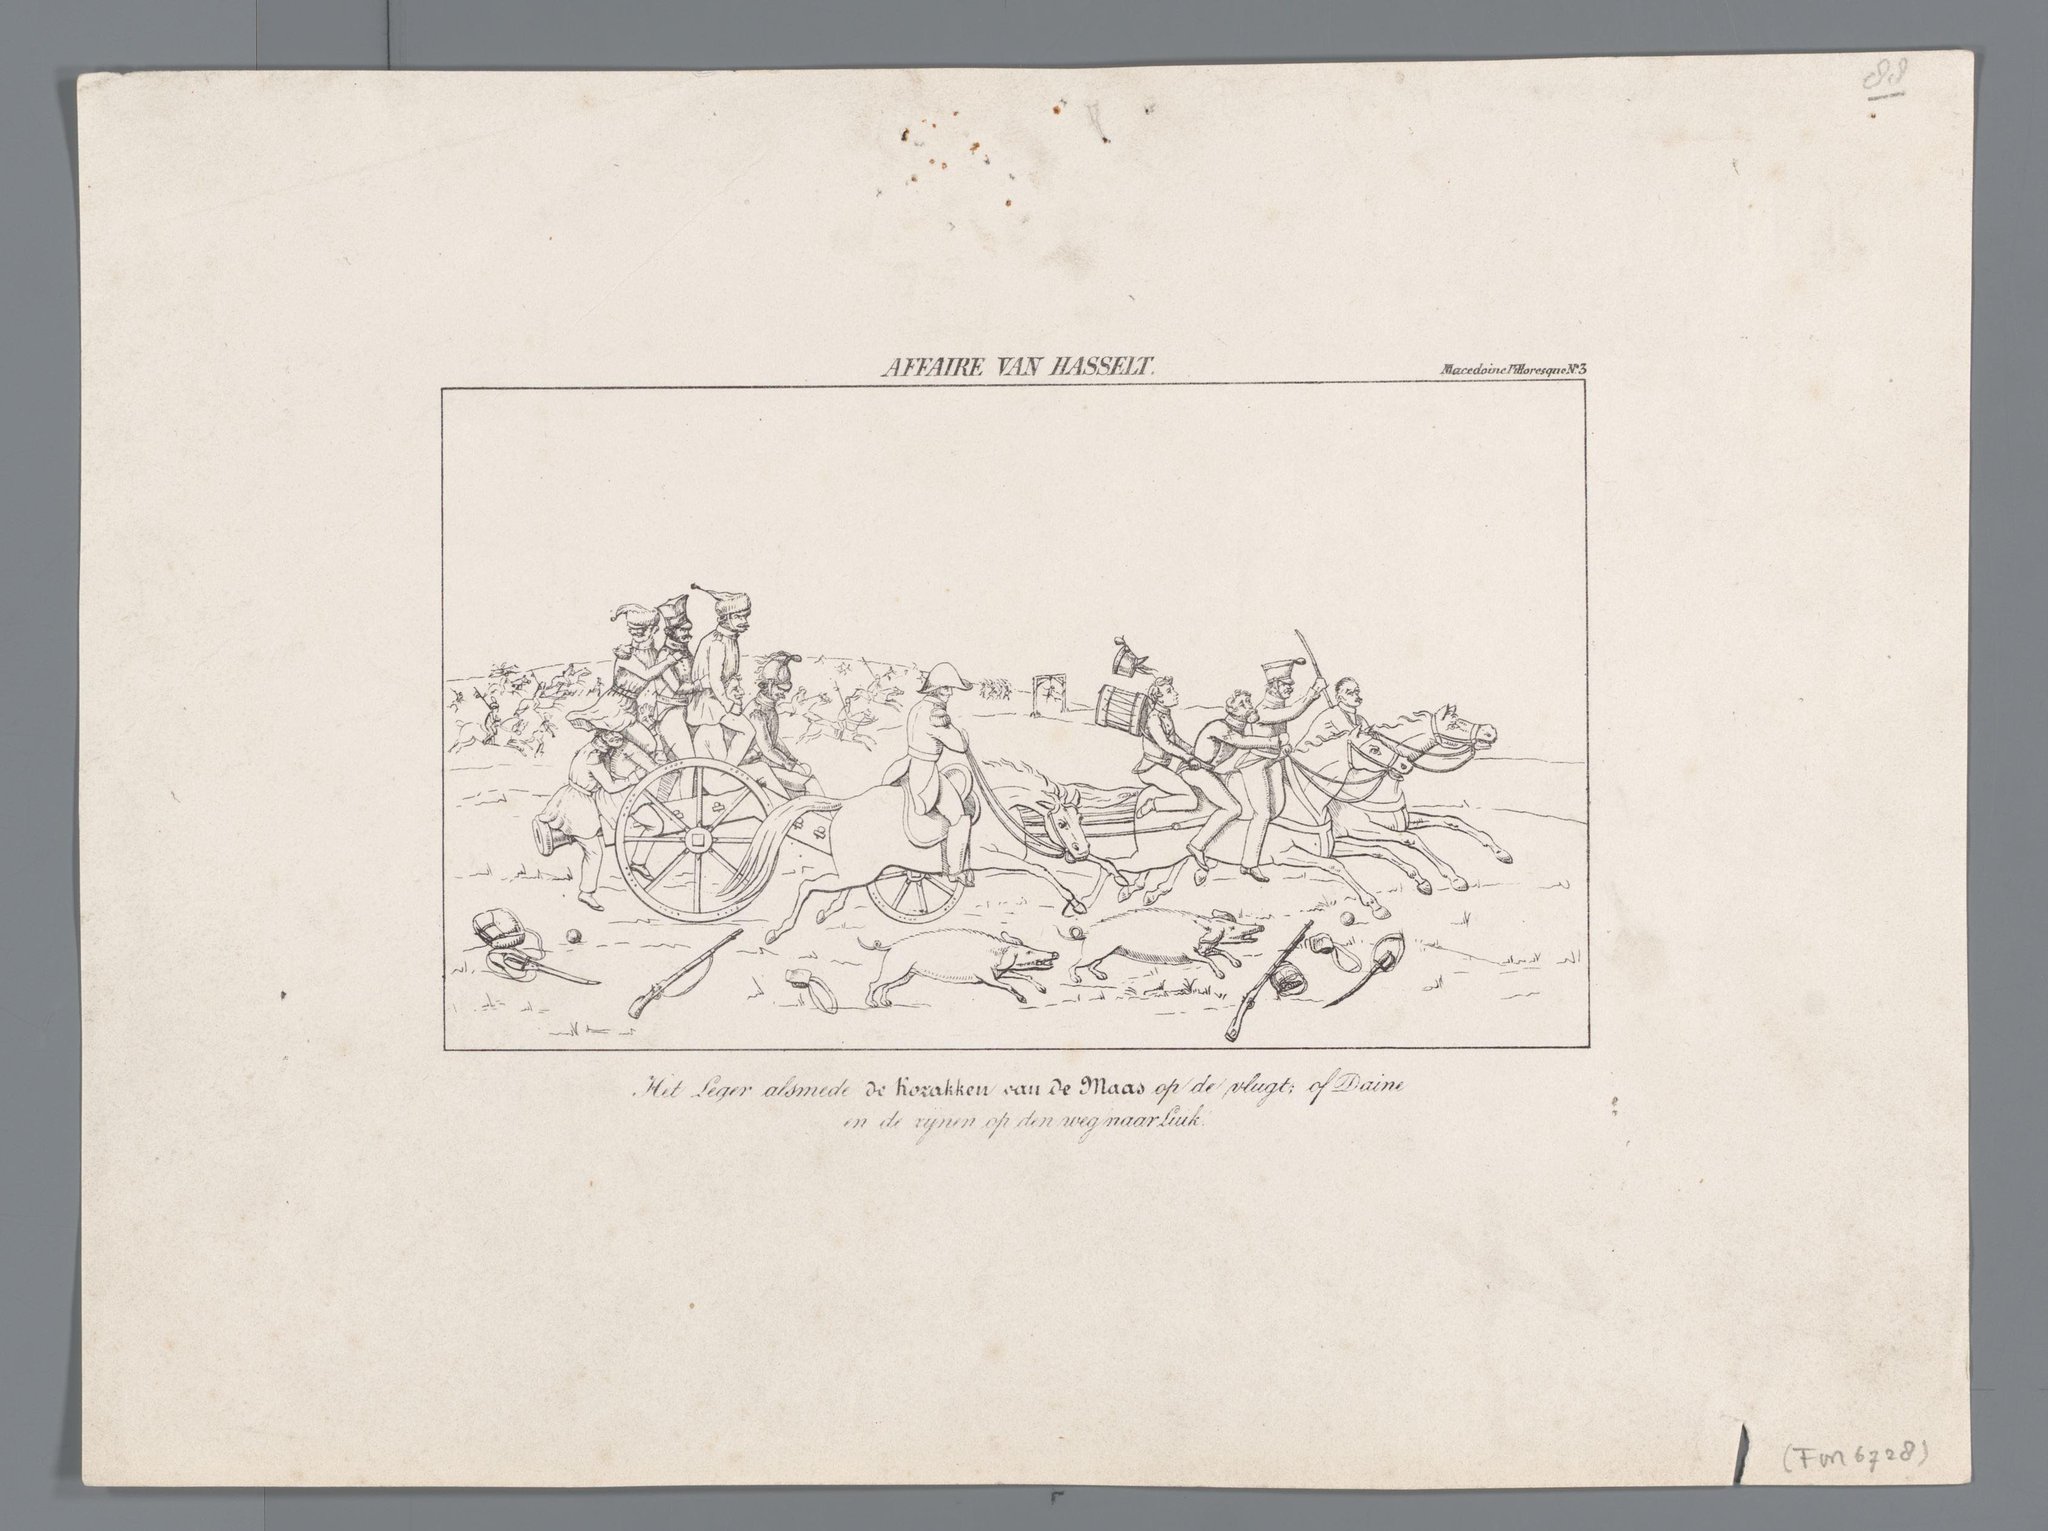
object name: cartoon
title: Affaire van Hasselt / Het Leger alsmede de Kozakken van de Maas op de vlugt; of Daine en de zijnen op den weg naar Luik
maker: Anonymous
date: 1831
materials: paper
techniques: lithograph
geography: netherlands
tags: putting the enemy to flight - hh - being put to flight, fleeing, retreat of the defeated, political caricatures and satires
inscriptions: caption: ‘Het leger alsmede de Kozakken van de Maas op de Vlugt; of Daine en de zijnen op den weg naar Luik.’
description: Spotprent op de vlucht van het Belgische leger na het verlies in de slag bij Hasselt op 8 augustus 1831. Generaal Daine slaat met zijn manschappen en twee varkens op de vlucht.